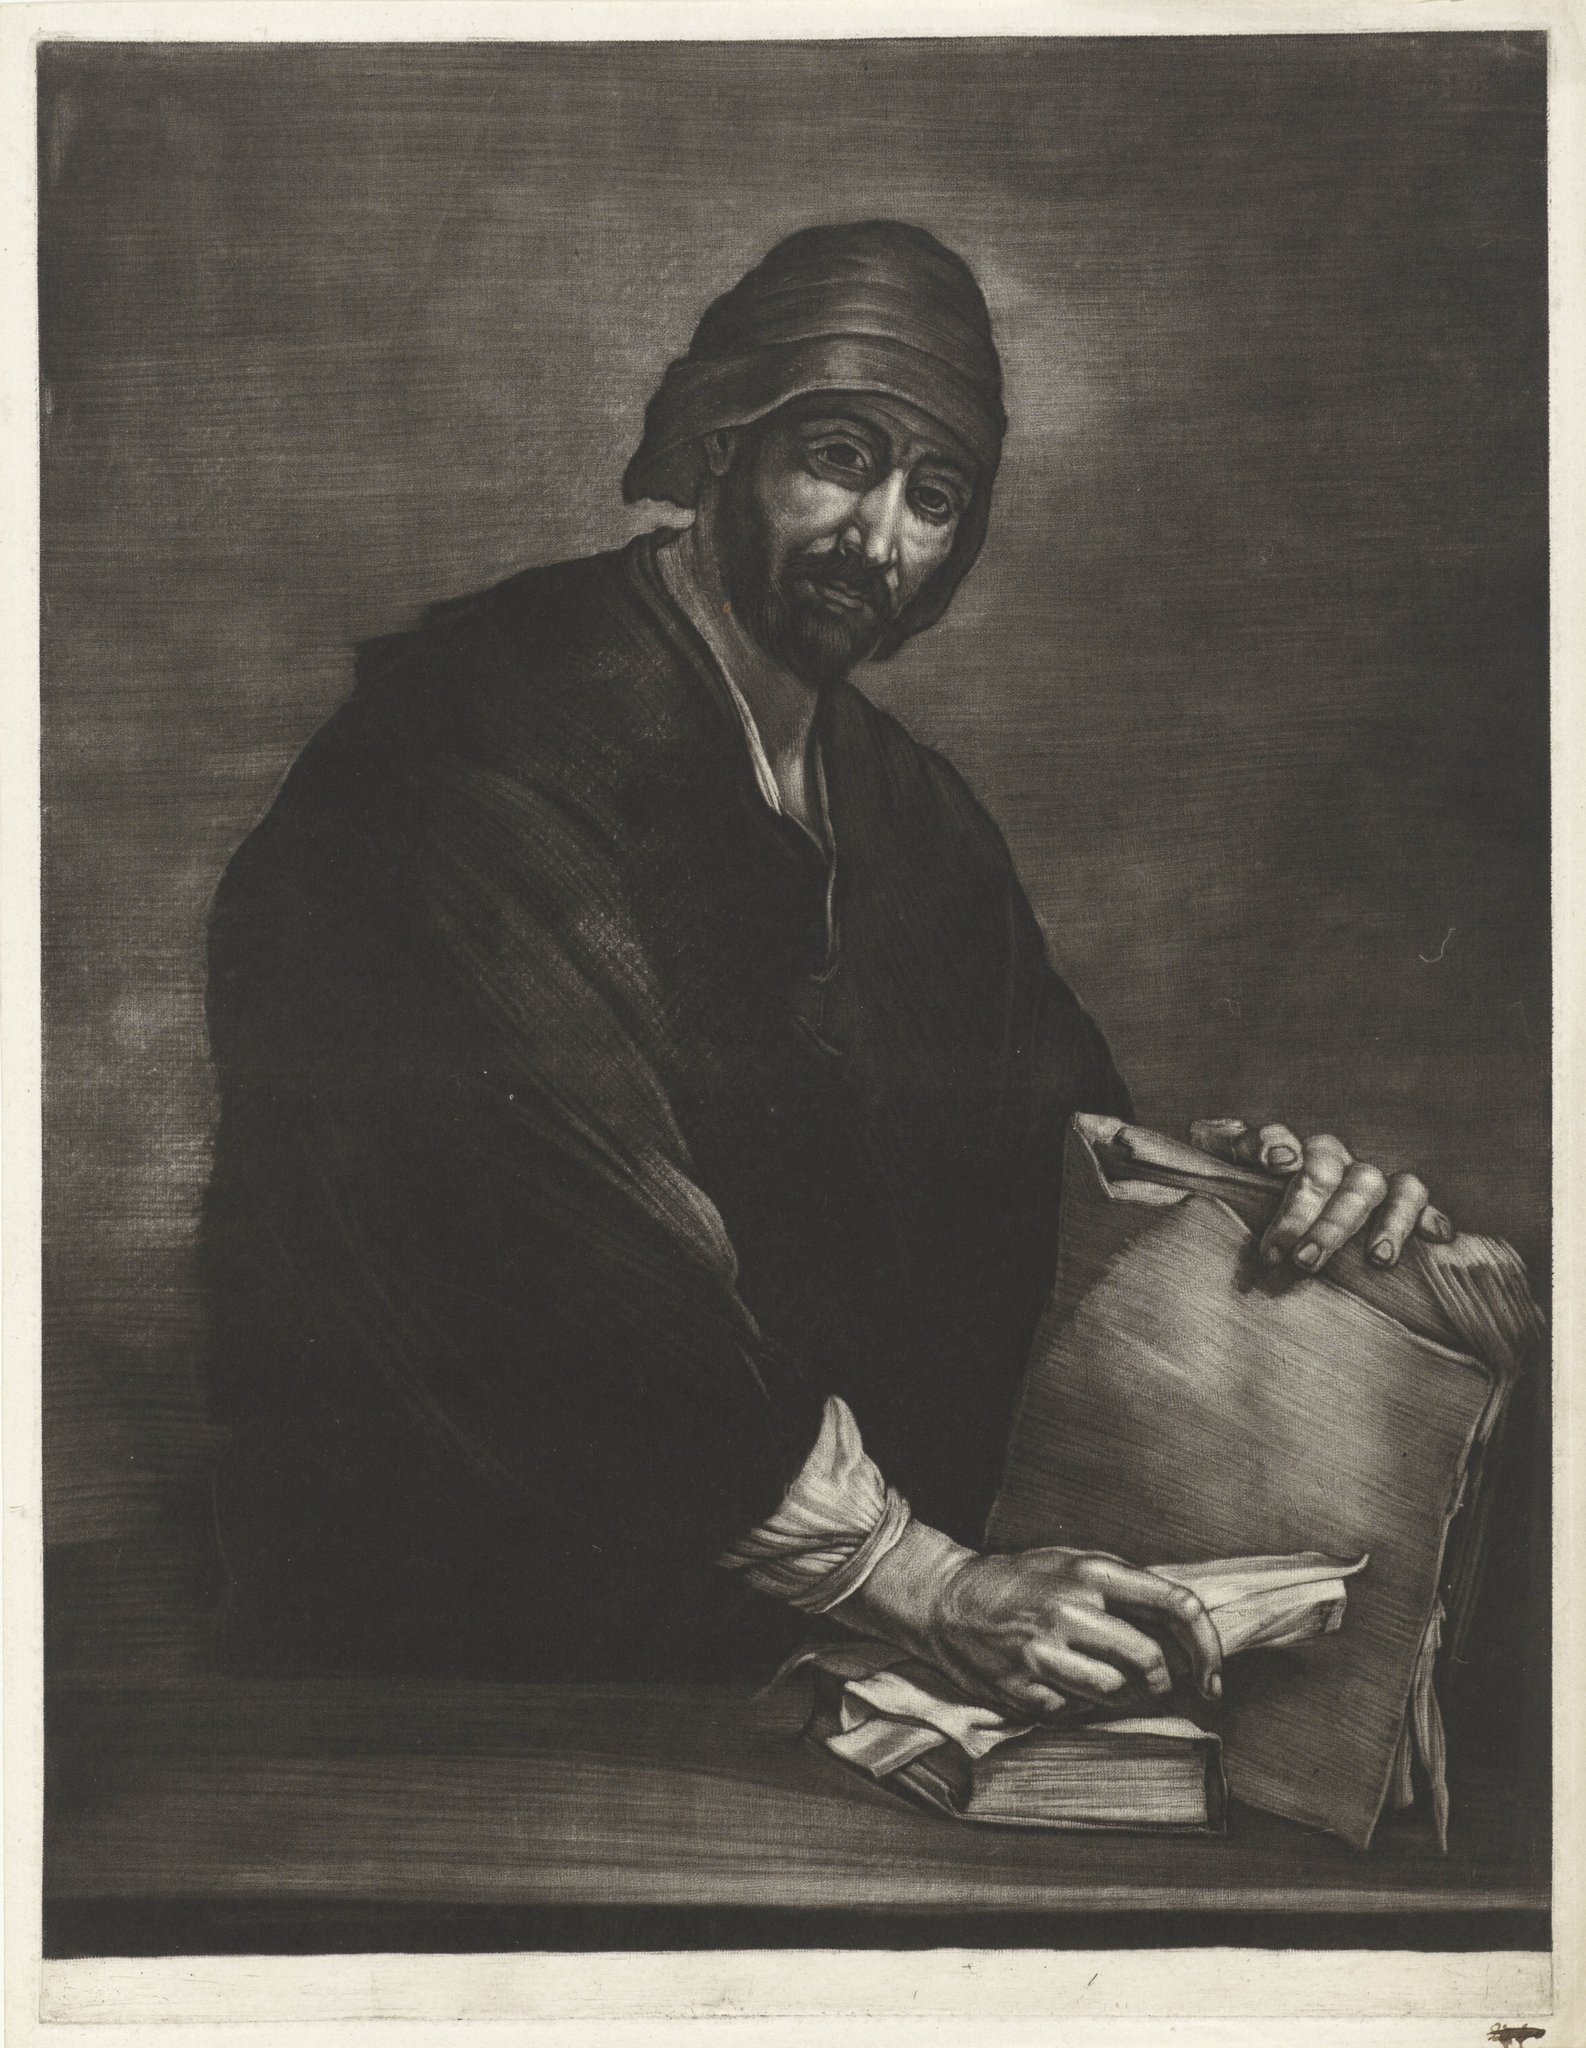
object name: print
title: Filosofen naar Spaanse voorbeelden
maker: bernard vaillant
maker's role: draughtsman, painter, print maker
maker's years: 1632-1698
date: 1672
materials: paper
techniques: mezzotint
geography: amsterdam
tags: scholar, philosopher, book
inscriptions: collector's mark: Lugt 2760, collector's mark: Lugt 2228